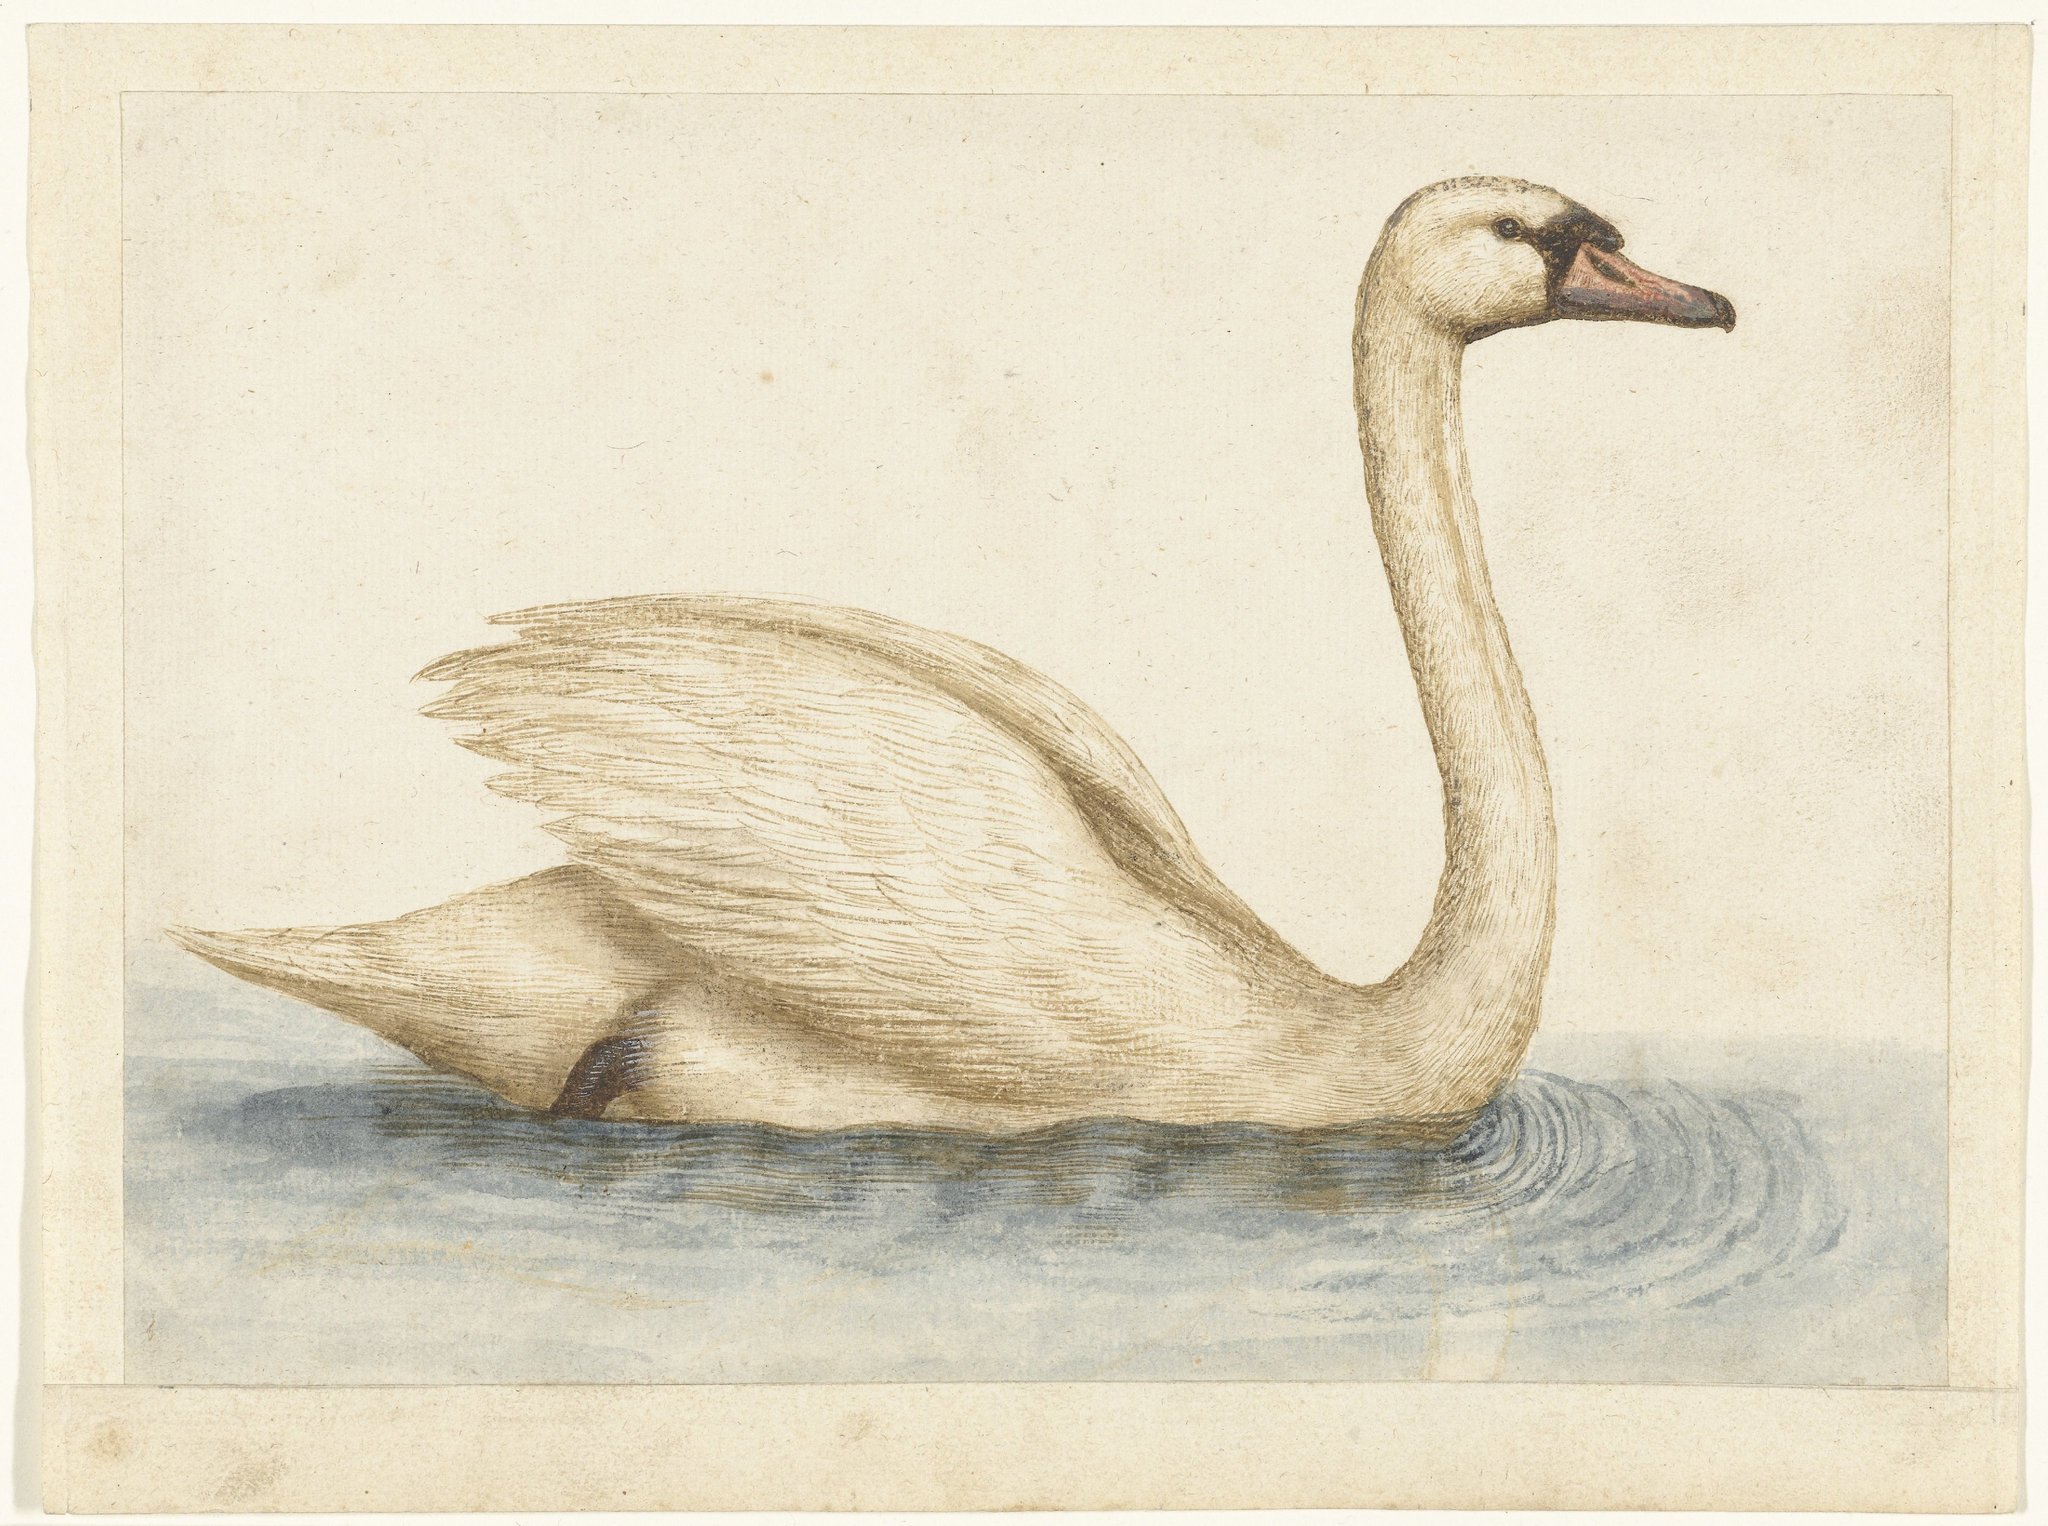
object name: drawing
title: Knobbelzwaan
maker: Anonymous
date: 1560-1585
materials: paper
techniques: brush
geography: low countries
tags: water-birds: swan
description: Blad uit album van 100 (?) bladen met tekeningen van dieren.